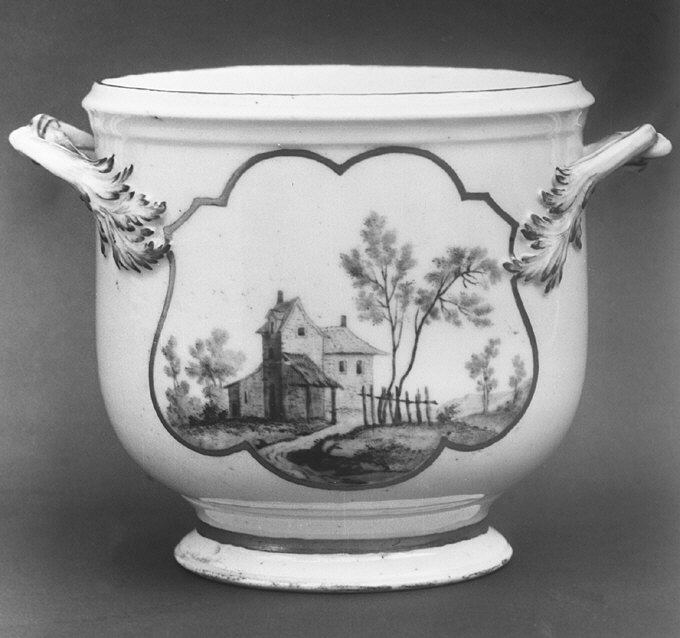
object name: wine cooler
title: Wine glass cooler (seau à verre)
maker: vincennes manufactory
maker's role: manufactory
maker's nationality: french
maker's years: 1740-1756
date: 1750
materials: soft paste porcelain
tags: houses,trees